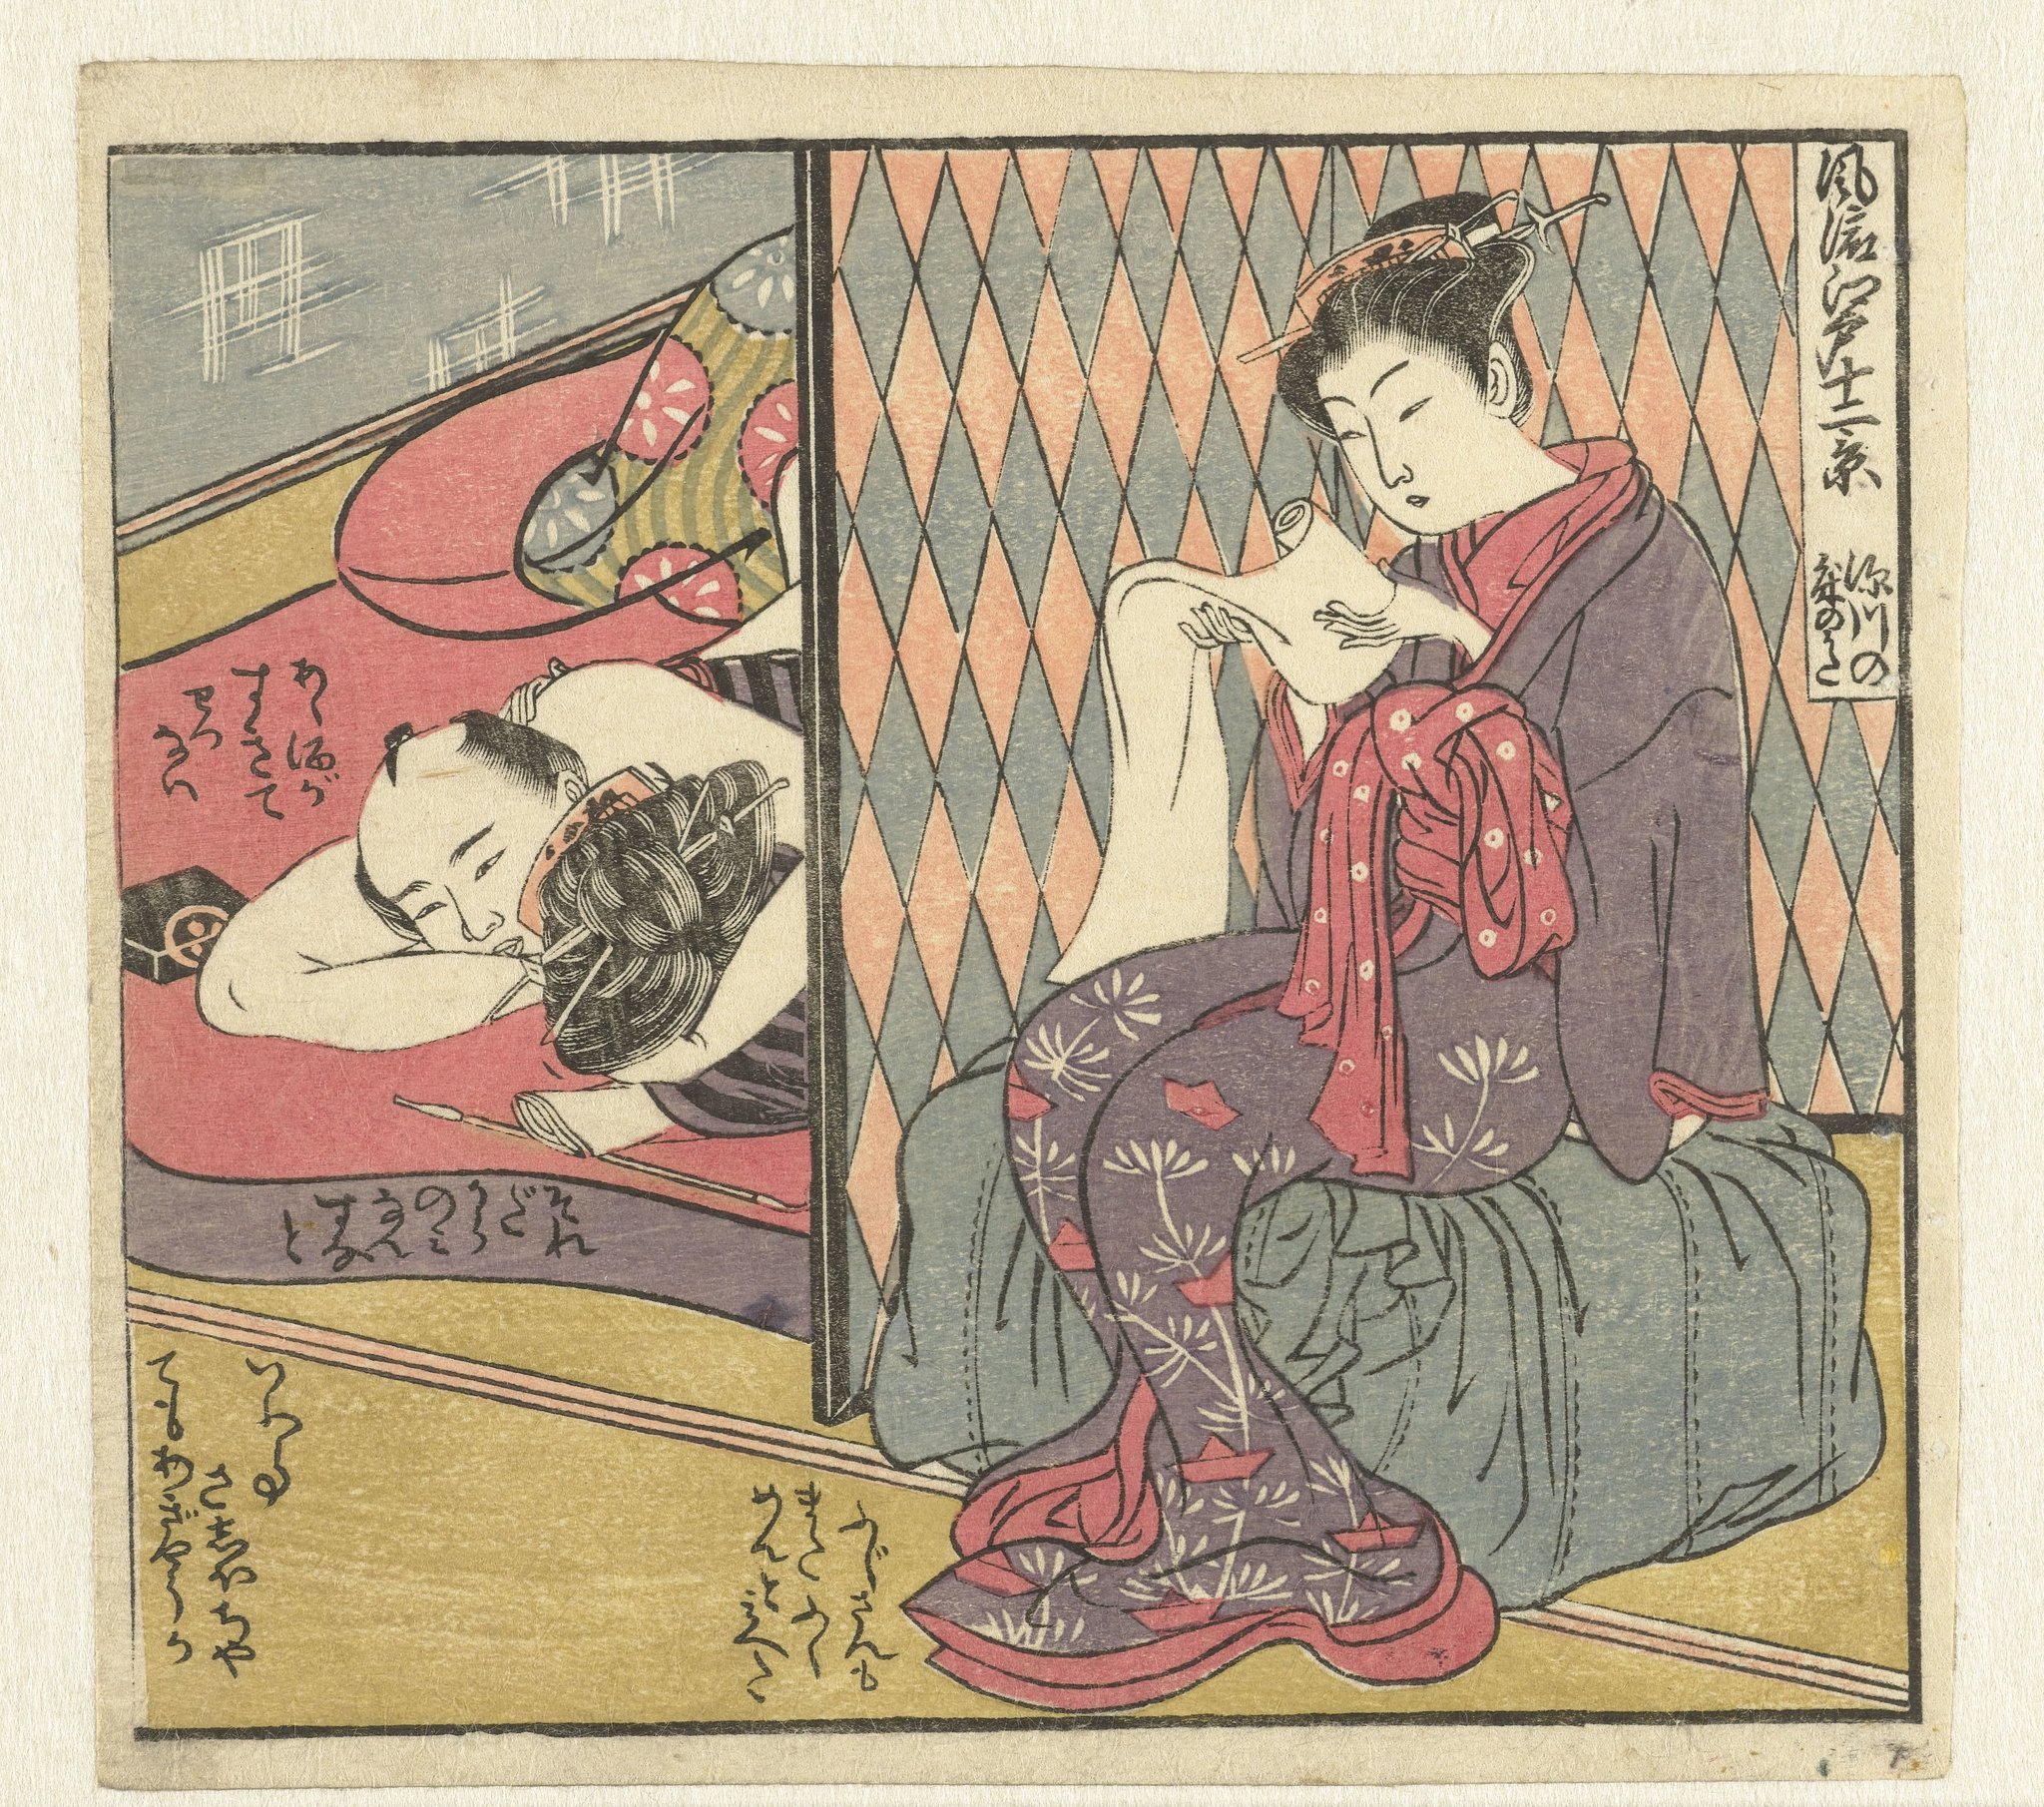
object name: print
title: Furyu Edo junikei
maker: isoda kôryûsai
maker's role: print maker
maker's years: 1735-1790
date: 1770-1775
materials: paper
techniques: woodcut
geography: japan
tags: adult woman, reading, man and woman cohabiting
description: Lezende dame bij kamerscherm, waarachter een naakte man, liggend op futon, een vrouw omarmend.